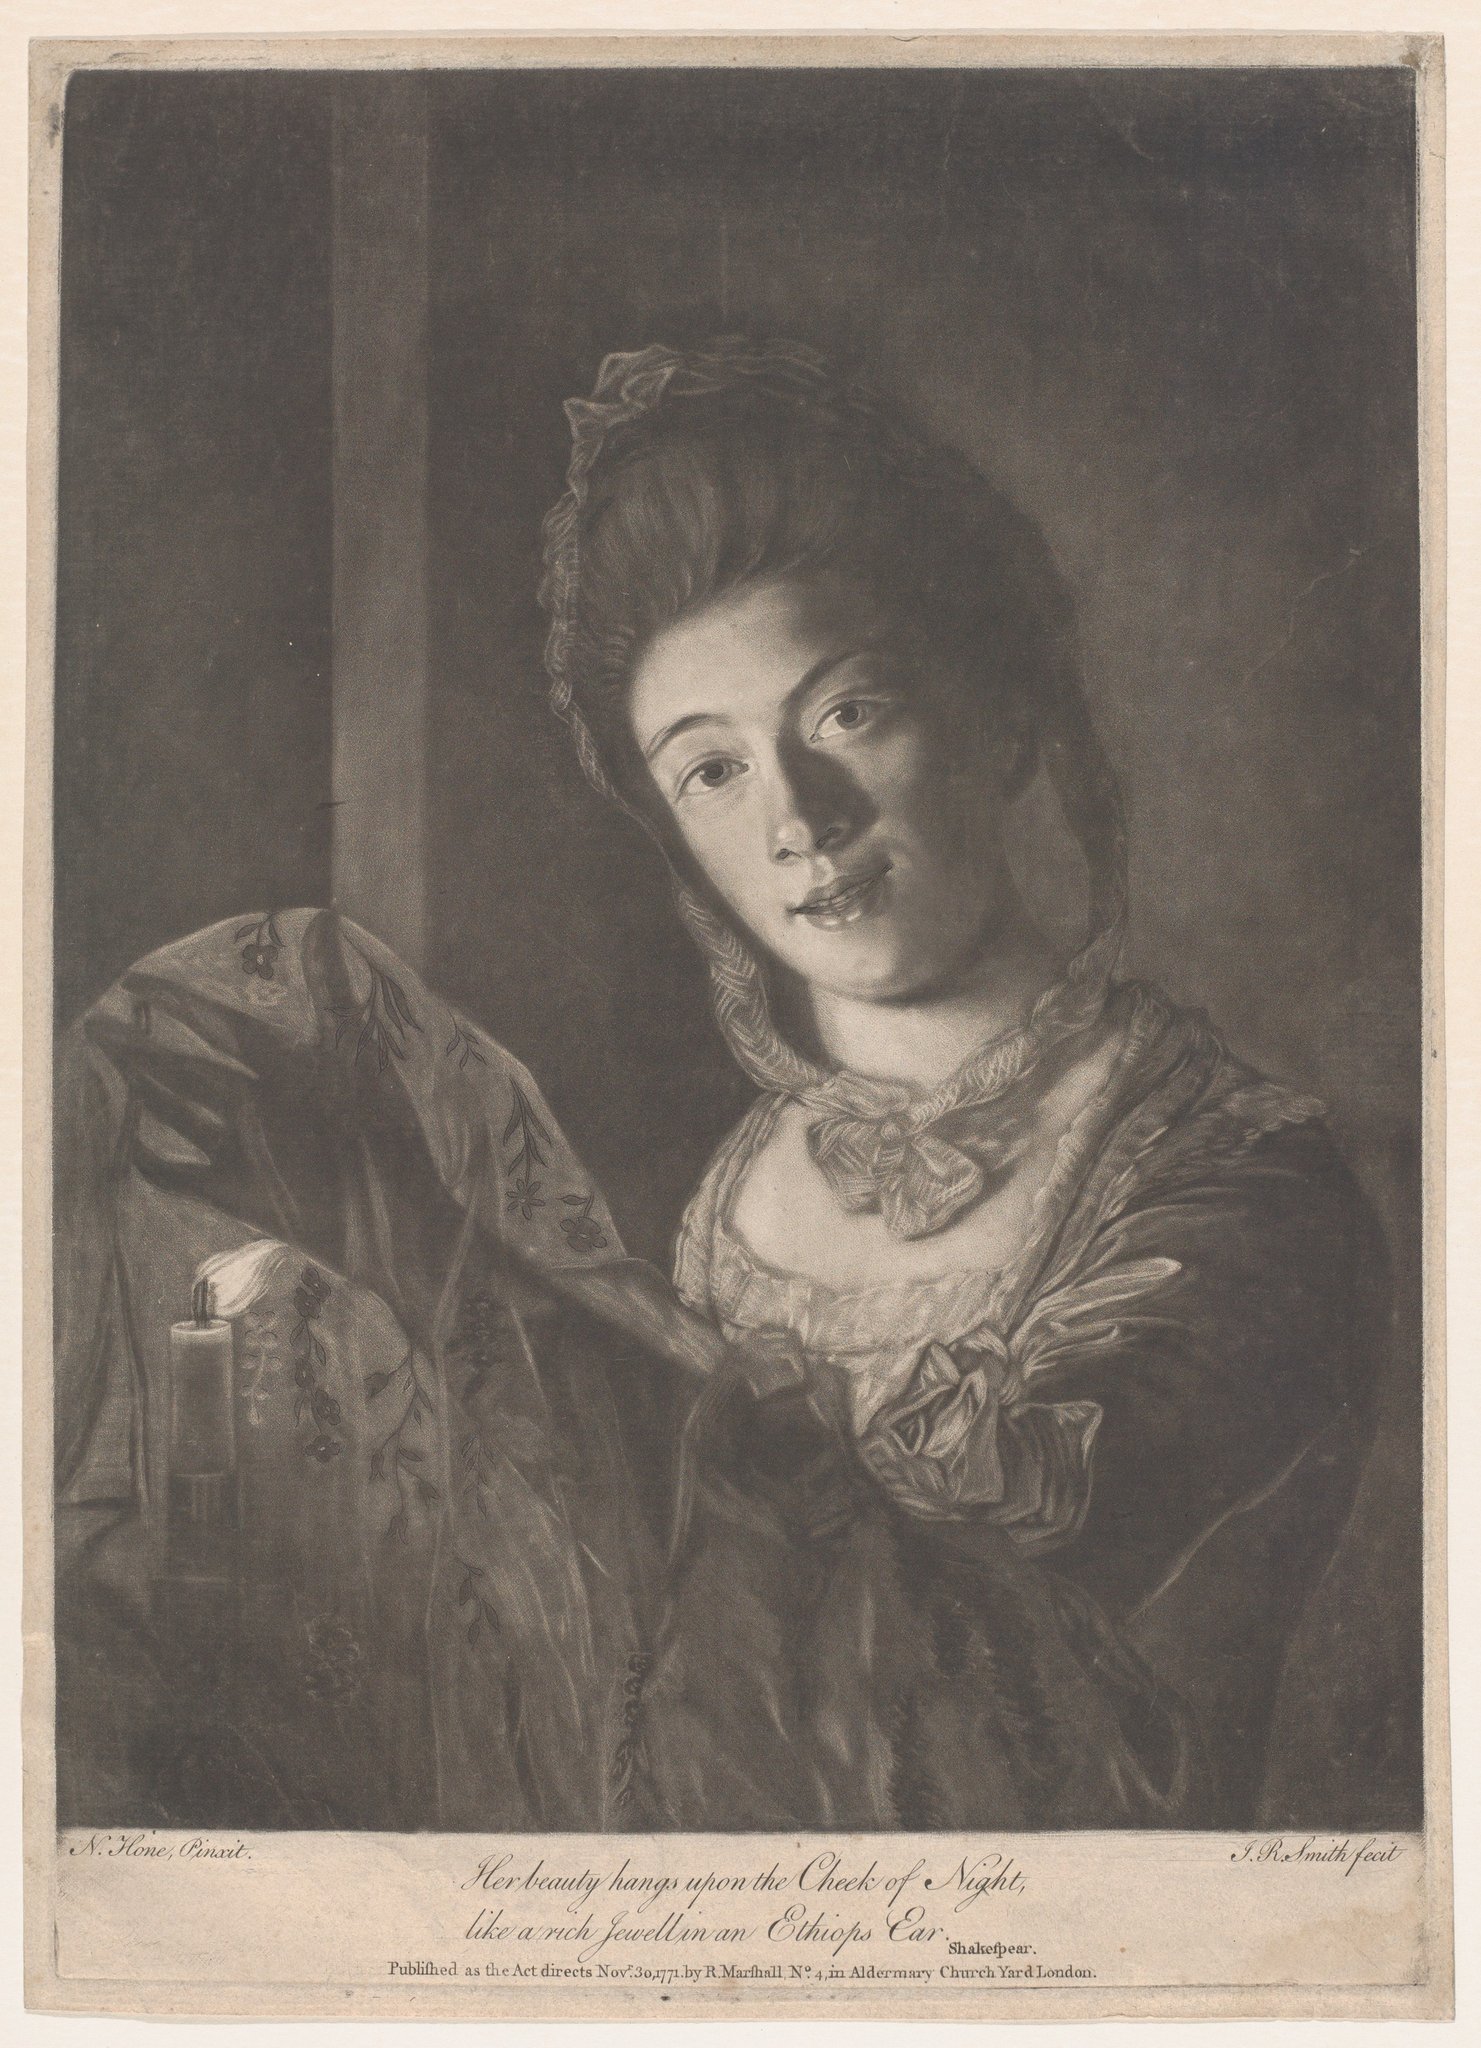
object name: print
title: Miss Lydia Hone – "Her beauty hangs on the Cheek of Night, like a rich Jewel in an Ethiop's Ear"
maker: john raphael smith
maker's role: engraver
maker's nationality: british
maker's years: 1751-1812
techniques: mezzotint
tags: shakespeare,women